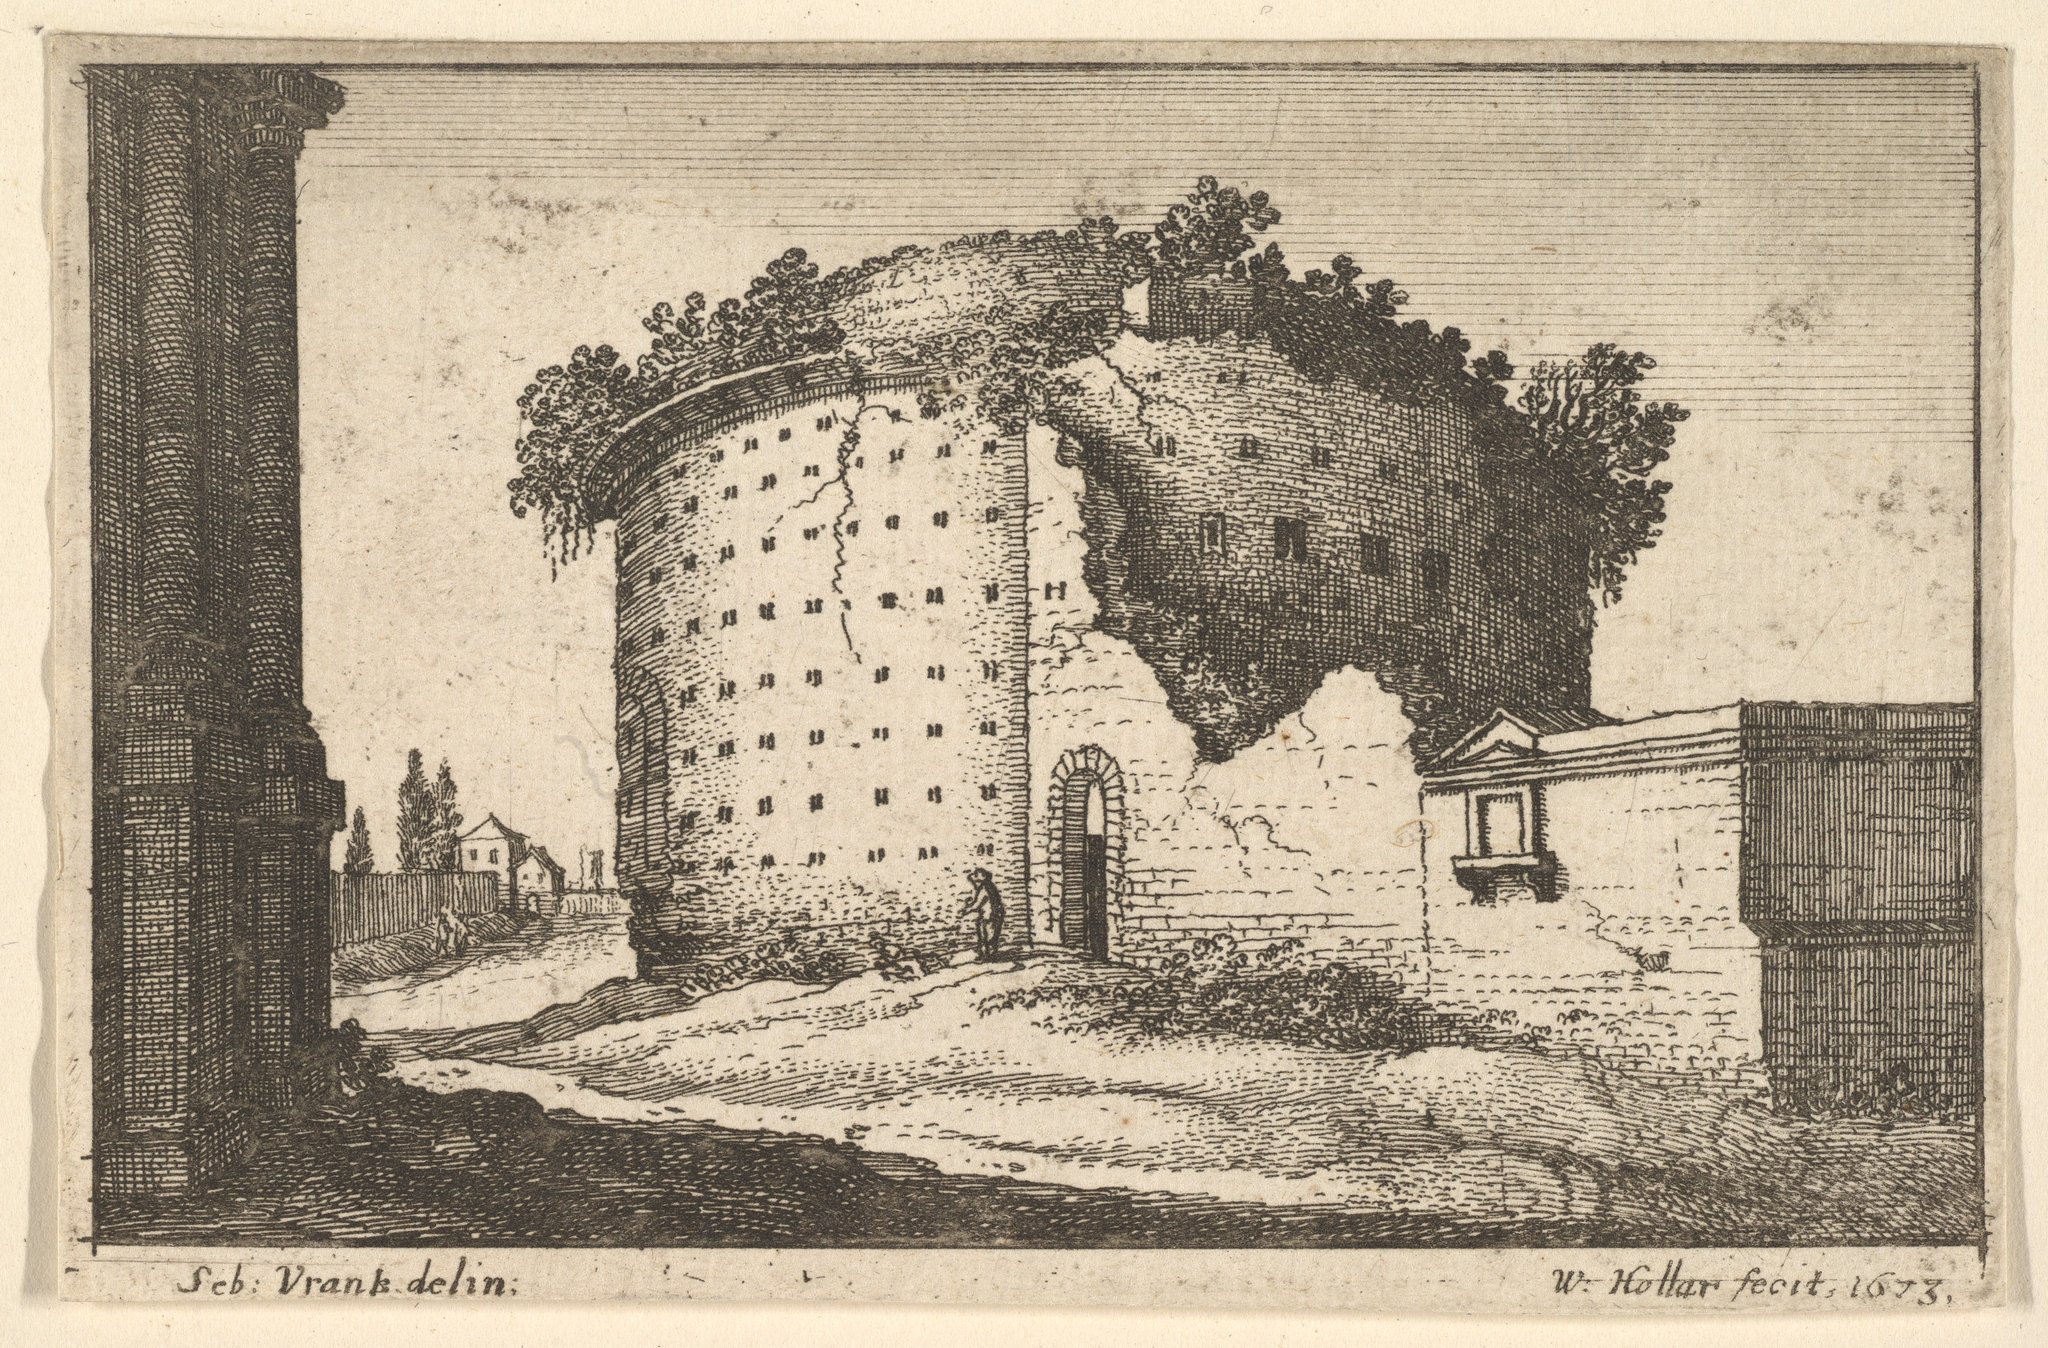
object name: print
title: Ruins of a round building, from "Roman Ruins"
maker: wenceslaus hollar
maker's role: artist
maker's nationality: bohemian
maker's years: 1607-1677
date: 1673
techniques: etching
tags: buildings,ruins